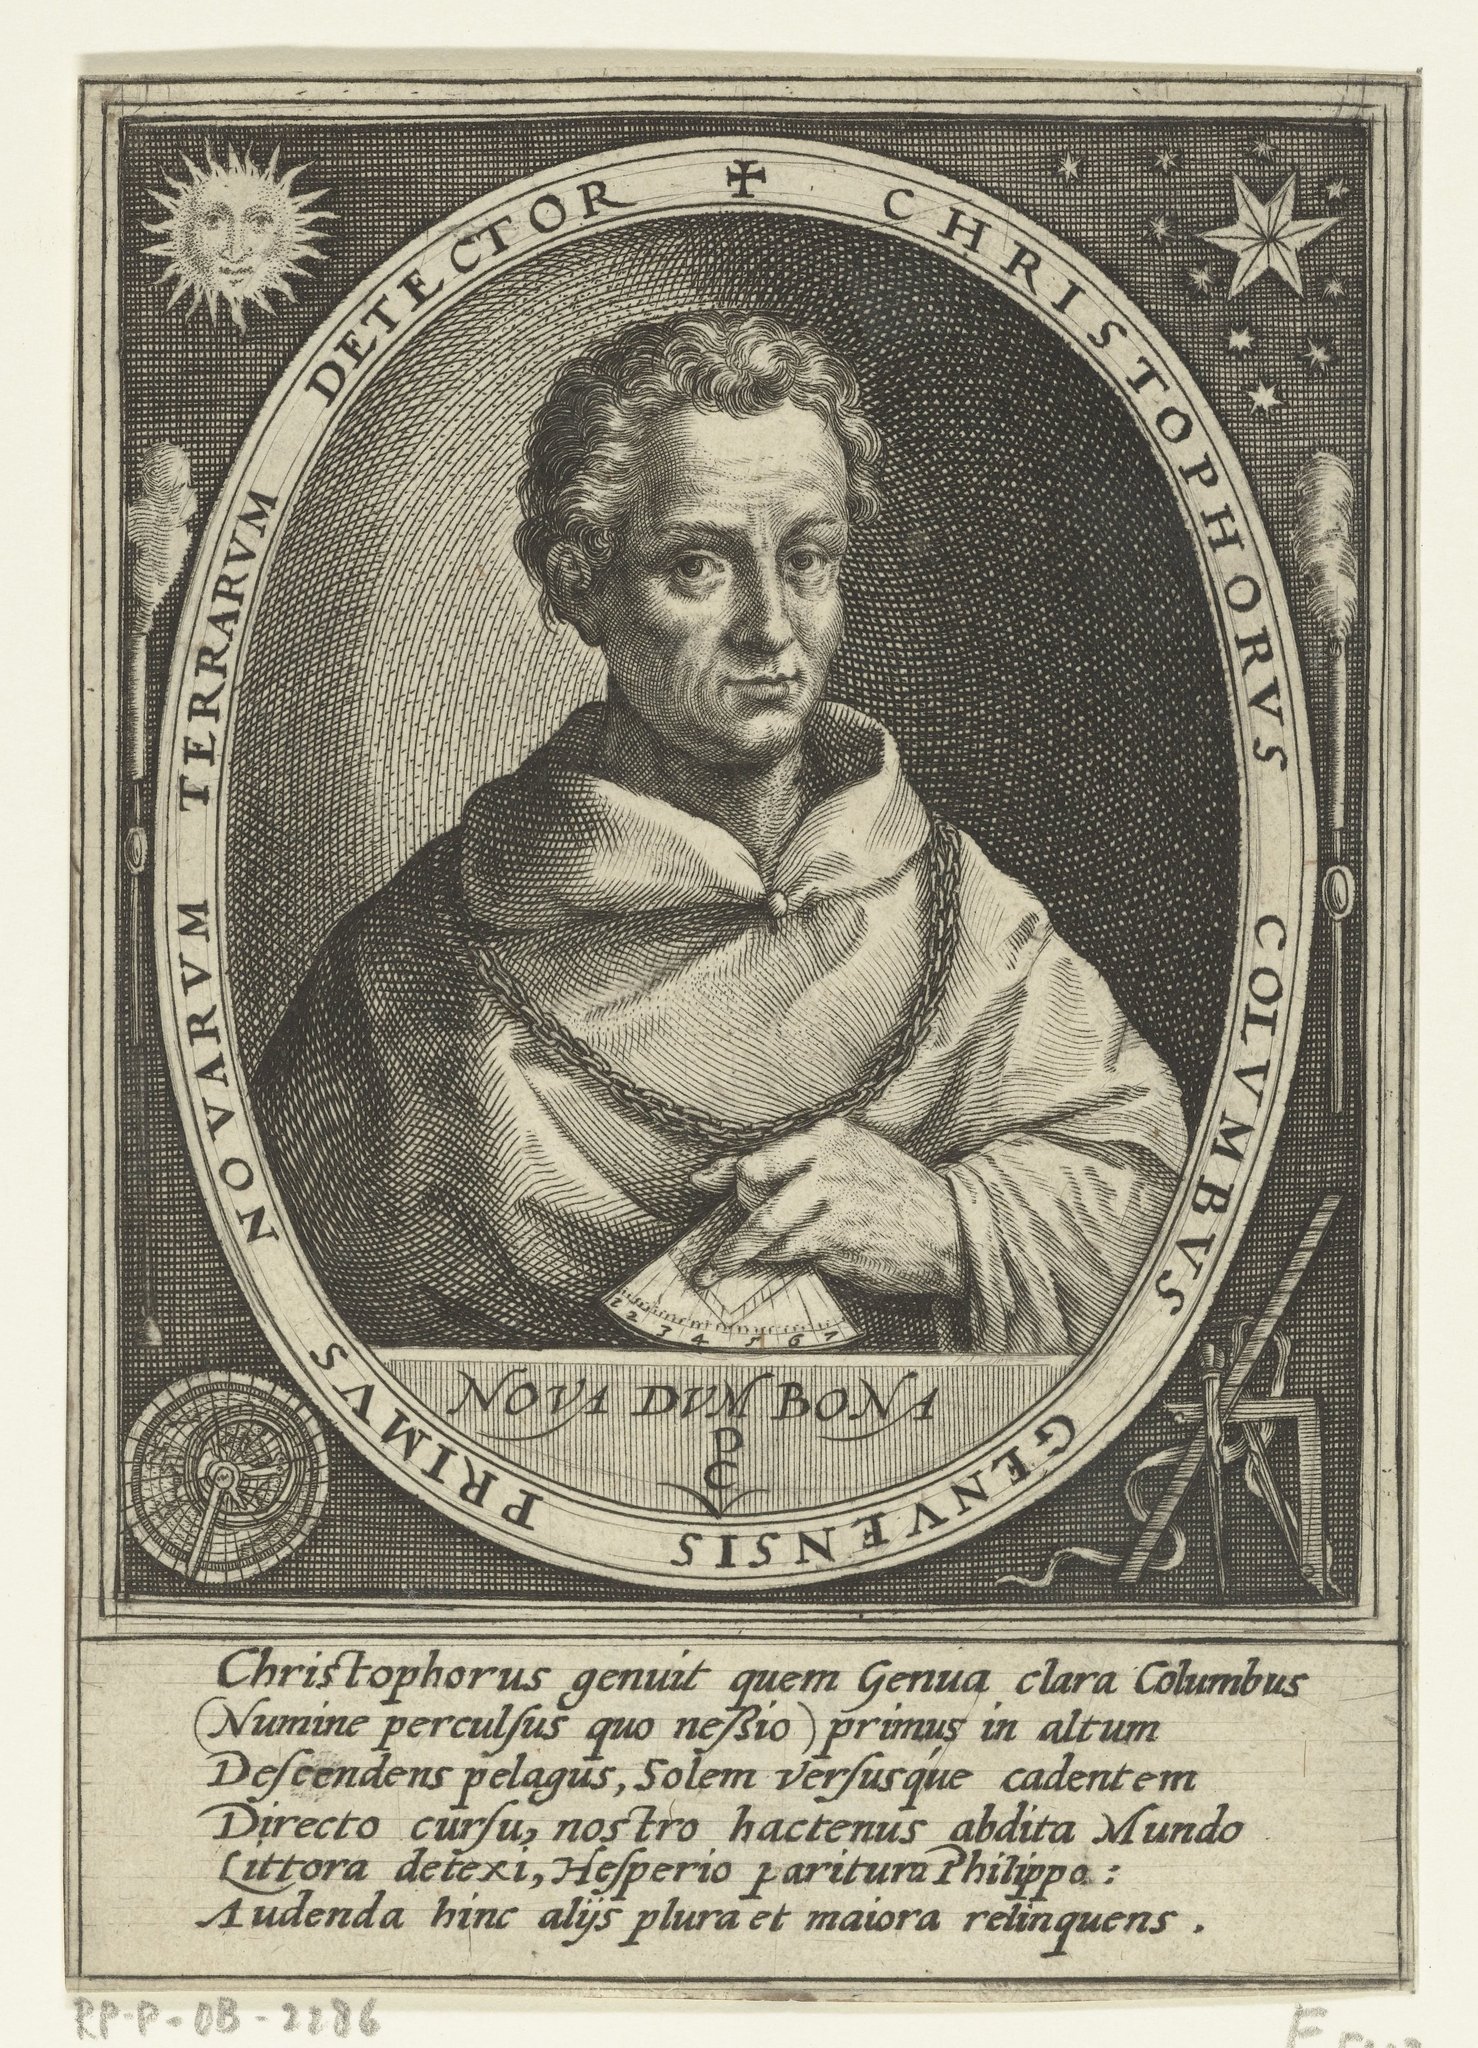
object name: print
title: Portret van Christoffel Columbus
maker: crispijn van de passe (i)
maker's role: draughtsman, print maker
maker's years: 1564-1637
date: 1598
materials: paper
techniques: engraving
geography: cologne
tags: quadrant, sextant, octant (nautical instruments)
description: Portret van de ontdekkingsreiziger Christoffel Columbus, eronder zijn devies in het Latijn. In het randschrift van de omlijsting de naam en functie van de geportretteerde in het Latijn. In de hoeken diverse navigatieinstrumenten. In de marge een zesregelig lofdicht in het Latijn.